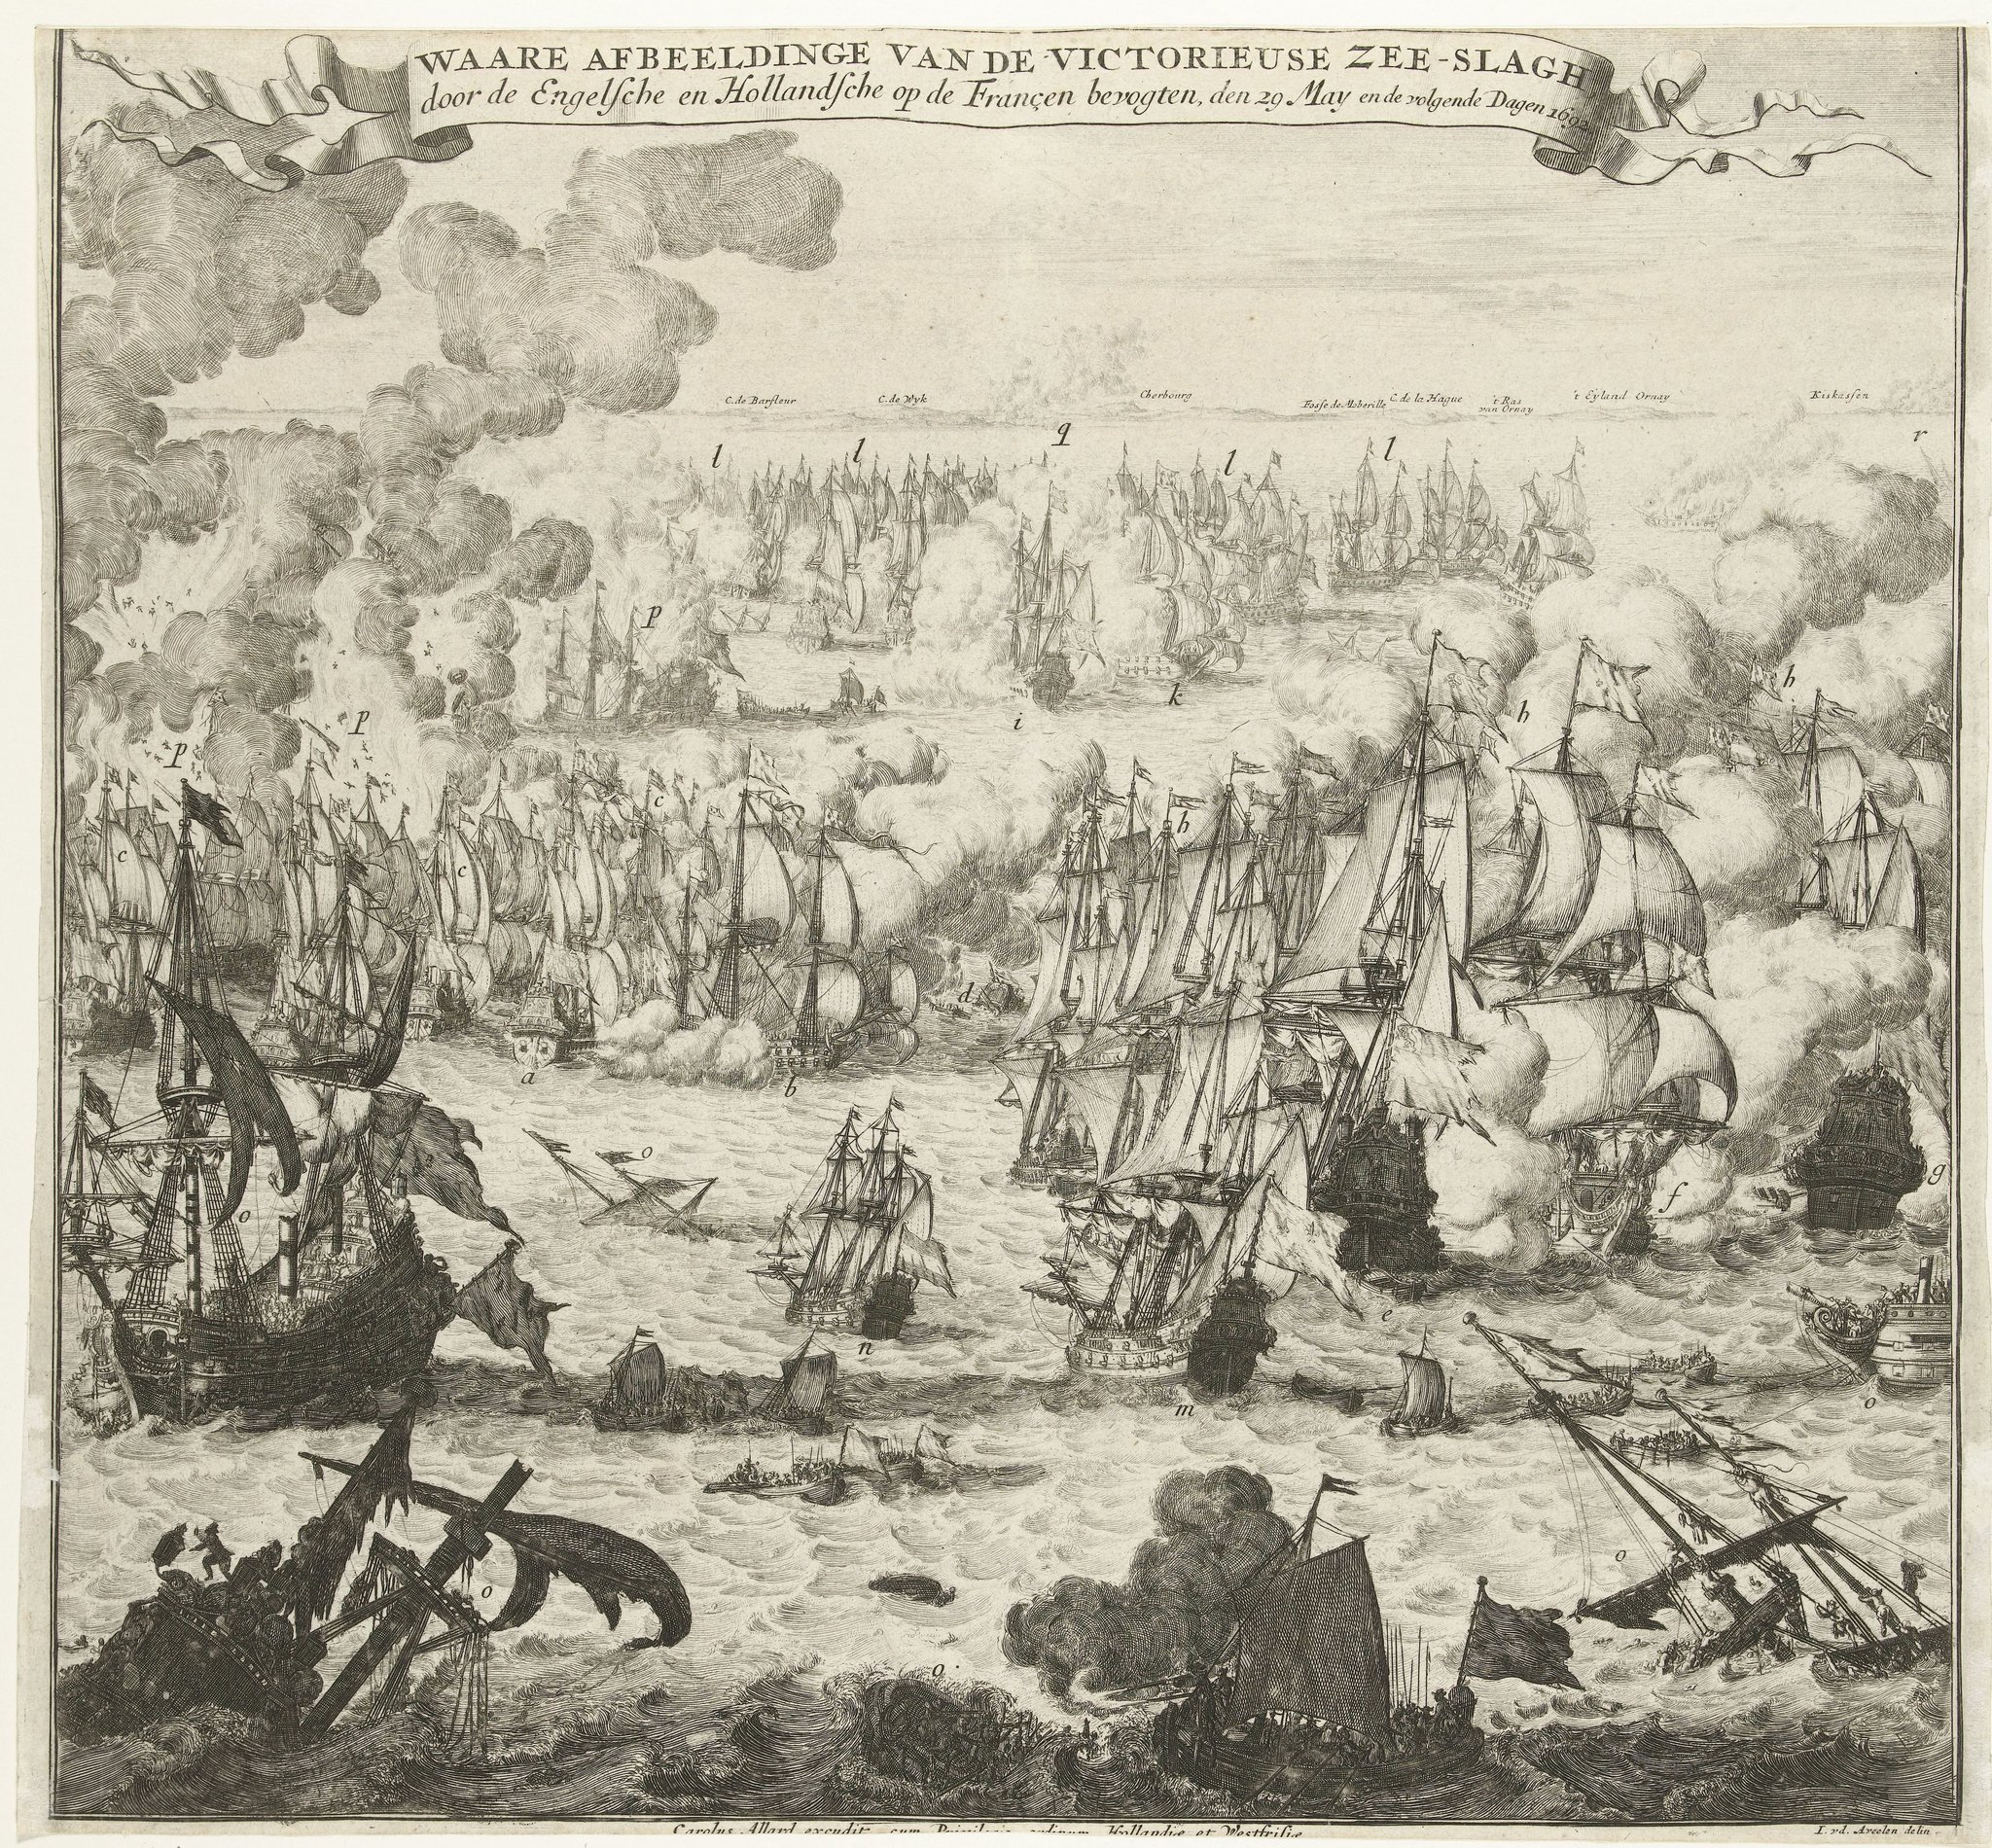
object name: print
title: Waare afbeeldinge van de victorieuse zee-slagh, door de Engelsche en Hollandsche op de Francen bevogten, den 29 May en de volgende Dagen 1692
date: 1692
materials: paper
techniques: engraving, etching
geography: amsterdam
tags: paris, battle (+ naval force)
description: Zeeslag bij Kaap la Hogue waarbij de Fransen onder admiraal de Tourville werden verslagen door de gecombineerde vloot van Engeland en Holland onder de admiralen Russel en Almonde, 29 mei t/m 3 juni 1692. Bij de plaat behoort een tekstblad.